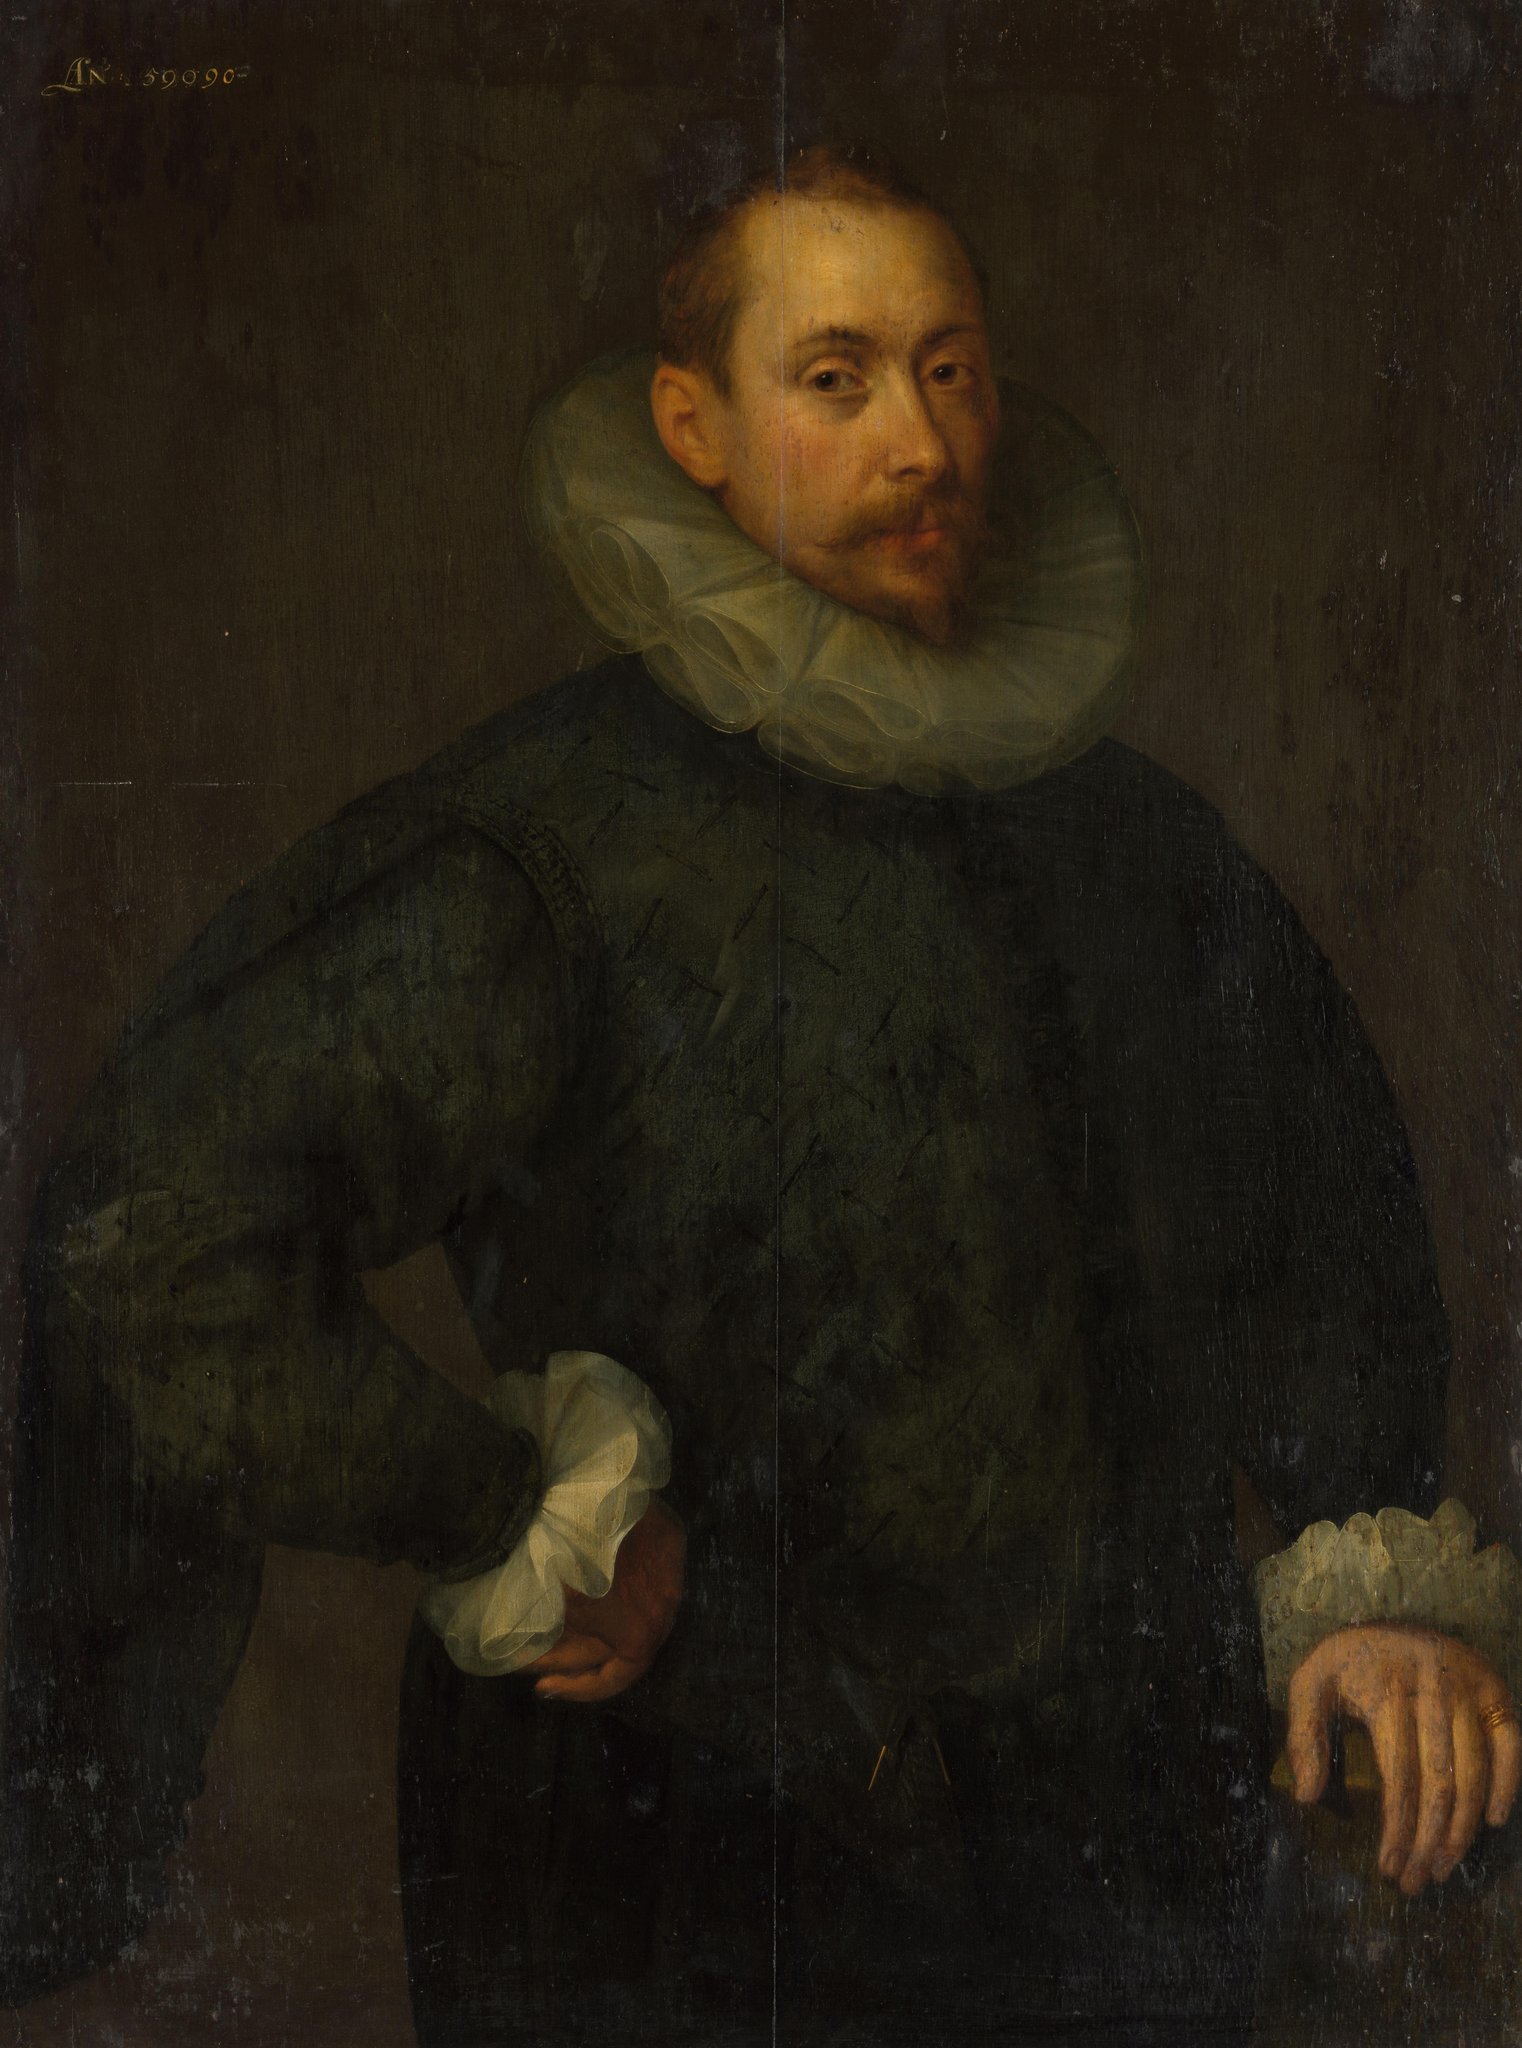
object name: painting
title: Jean Fourmenois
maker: gortzius geldorp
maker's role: painter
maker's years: 1553-1619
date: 1590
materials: oil, panel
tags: historical persons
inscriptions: inscription: ‘Jean Fourmenois. Trouwt te Keulen Hortensia del Prado. Geb: Overl: / 34’, date: ‘An. 59090’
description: Portret van Jean Fourmenois. Staande ten halven lijve met de linkerhand leunend op een tafel, de rechterhand in de zij. Op de achterkant een inscriptie met de naam en het cijfer 34. Pendant van SK-A-2072.